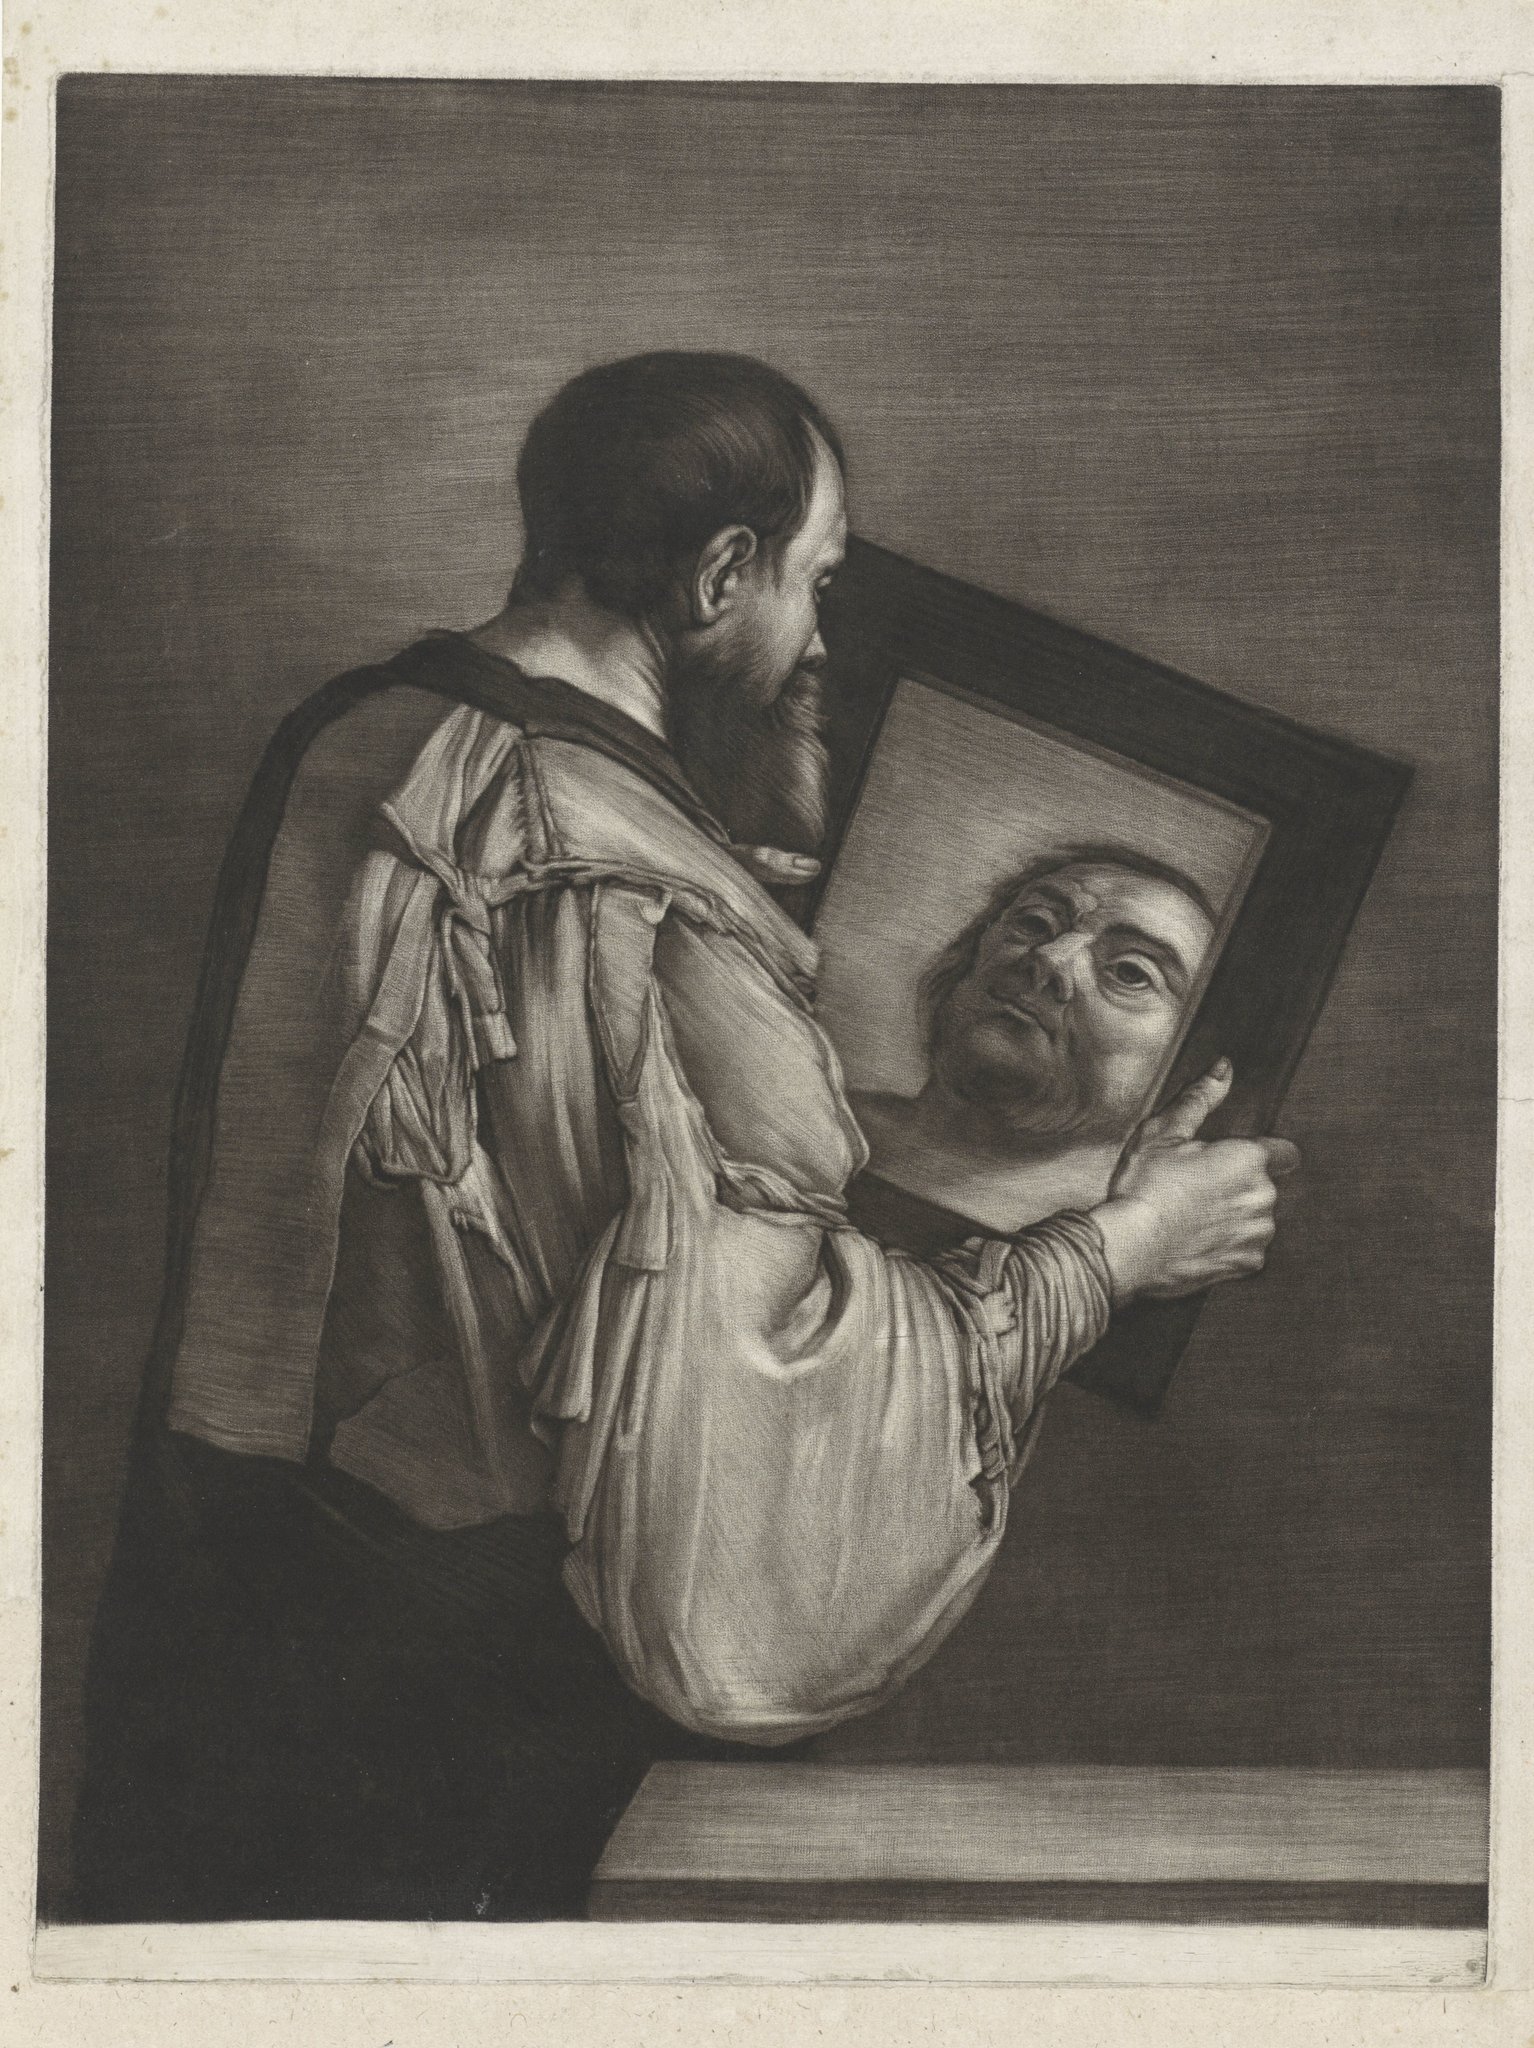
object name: print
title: Socrates bekijkt zichzelf in een spiegel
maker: bernard vaillant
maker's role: draughtsman, painter, print maker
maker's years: 1632-1698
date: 1672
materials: paper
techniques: mezzotint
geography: amsterdam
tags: scholar, philosopher, mirror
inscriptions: collector's mark: Lugt 240